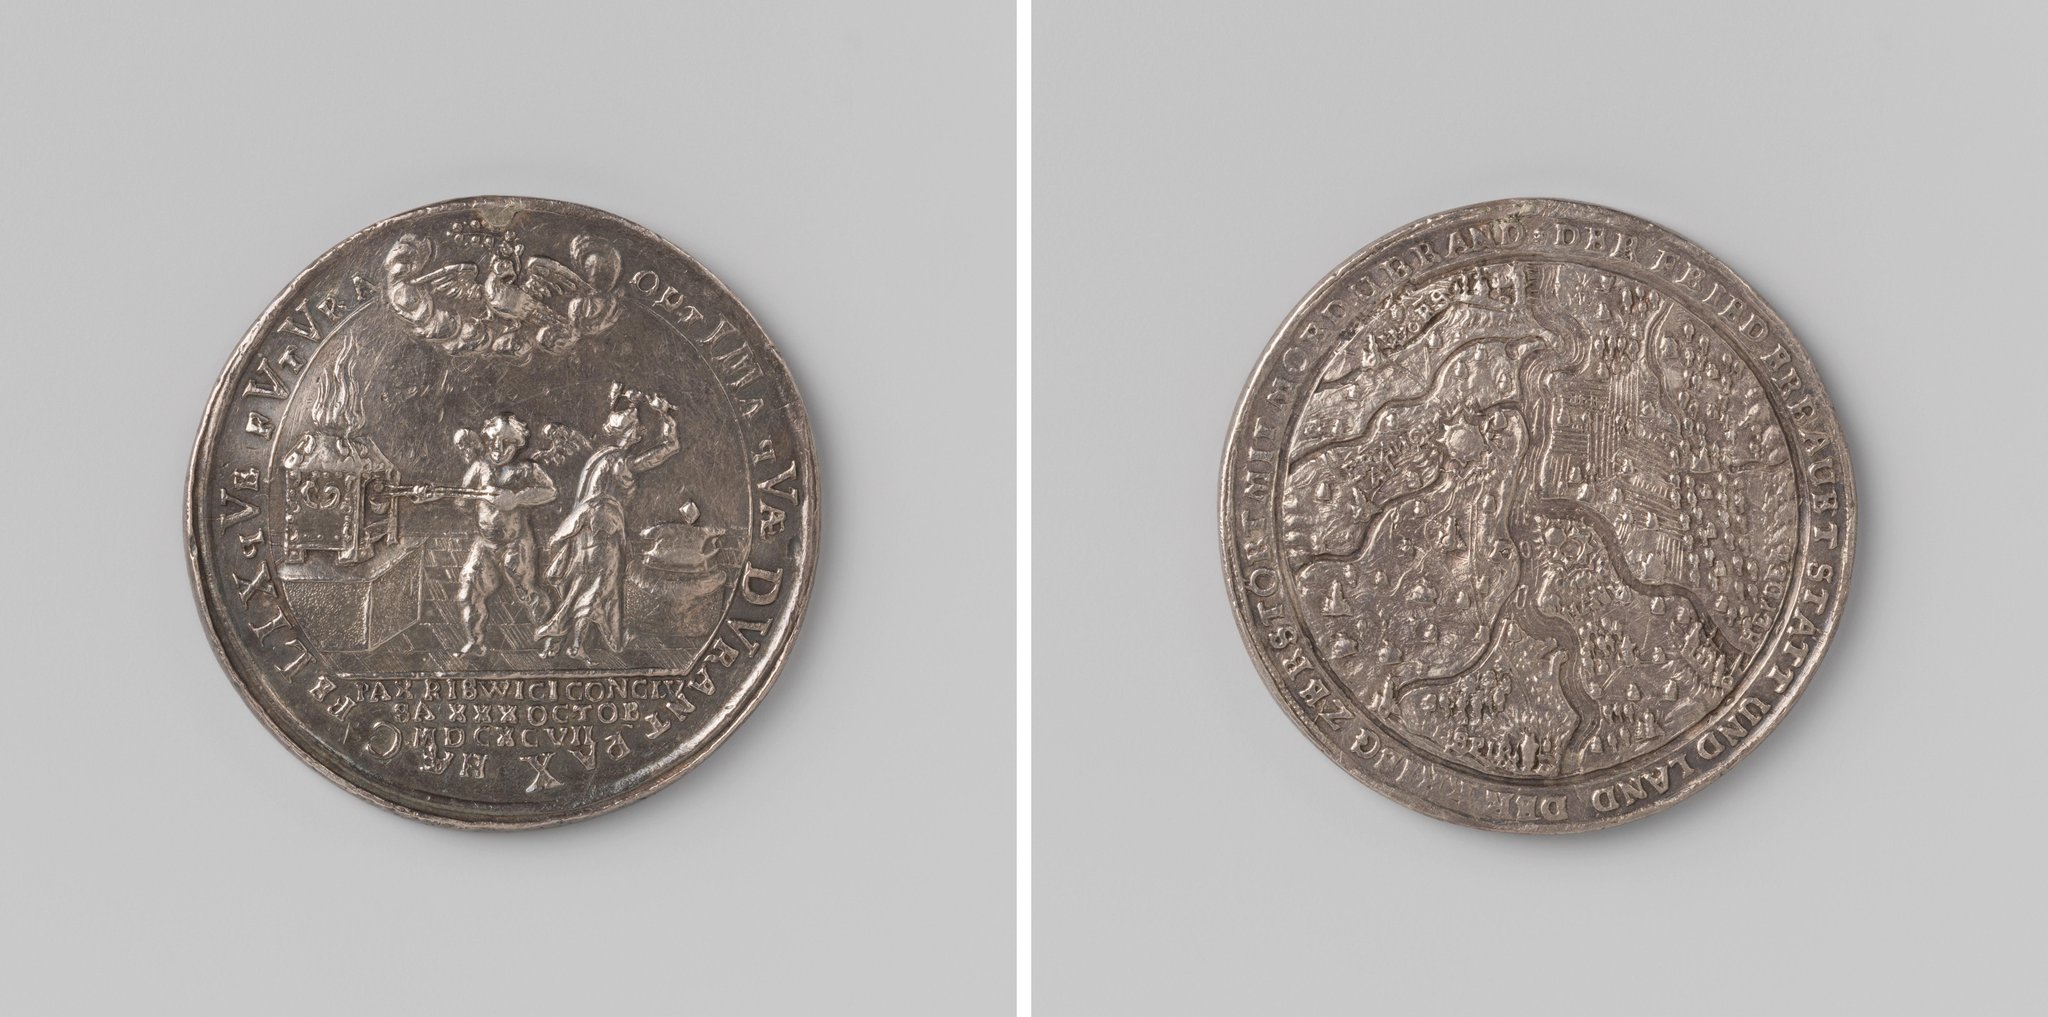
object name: history medal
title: Vrede van Rijswijk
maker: Anonymous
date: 1697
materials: silver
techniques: striking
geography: germany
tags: rijswijk, vrede van rijswijk (1697)